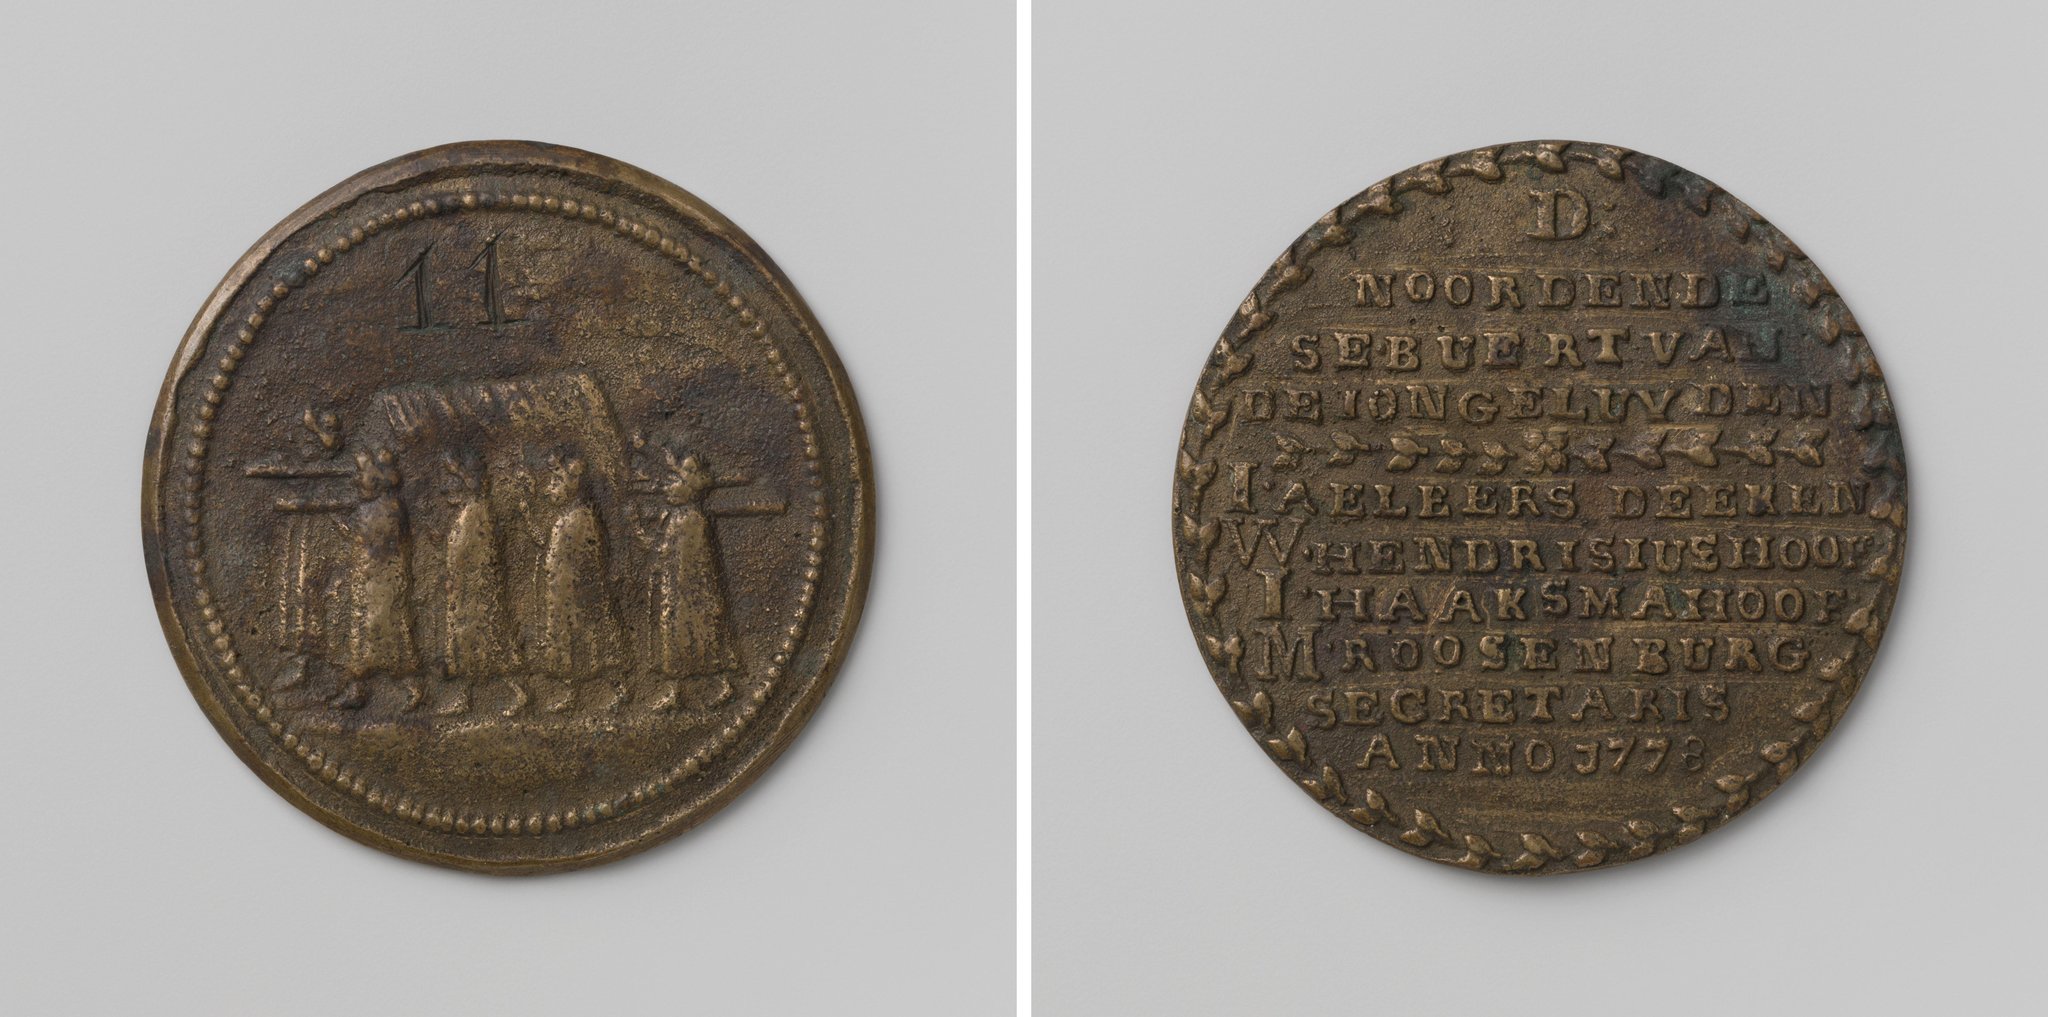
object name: buurtpenning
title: Buurt Noordeinde te 's-Gravenhage, begrafenispenning van de jongeluyden met no. 11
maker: Anonymous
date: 1778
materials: brass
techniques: casting, engraving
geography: the hague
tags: i. aelbers, w. hendrisius, i. haaksma, m. roosenburg, noordeinde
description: Messing penning. Voorzijde: zes mannen met lijkbaar onder cijfer 11 binnen parelrand. Keerzijde: opschrift binnen bladerkrans